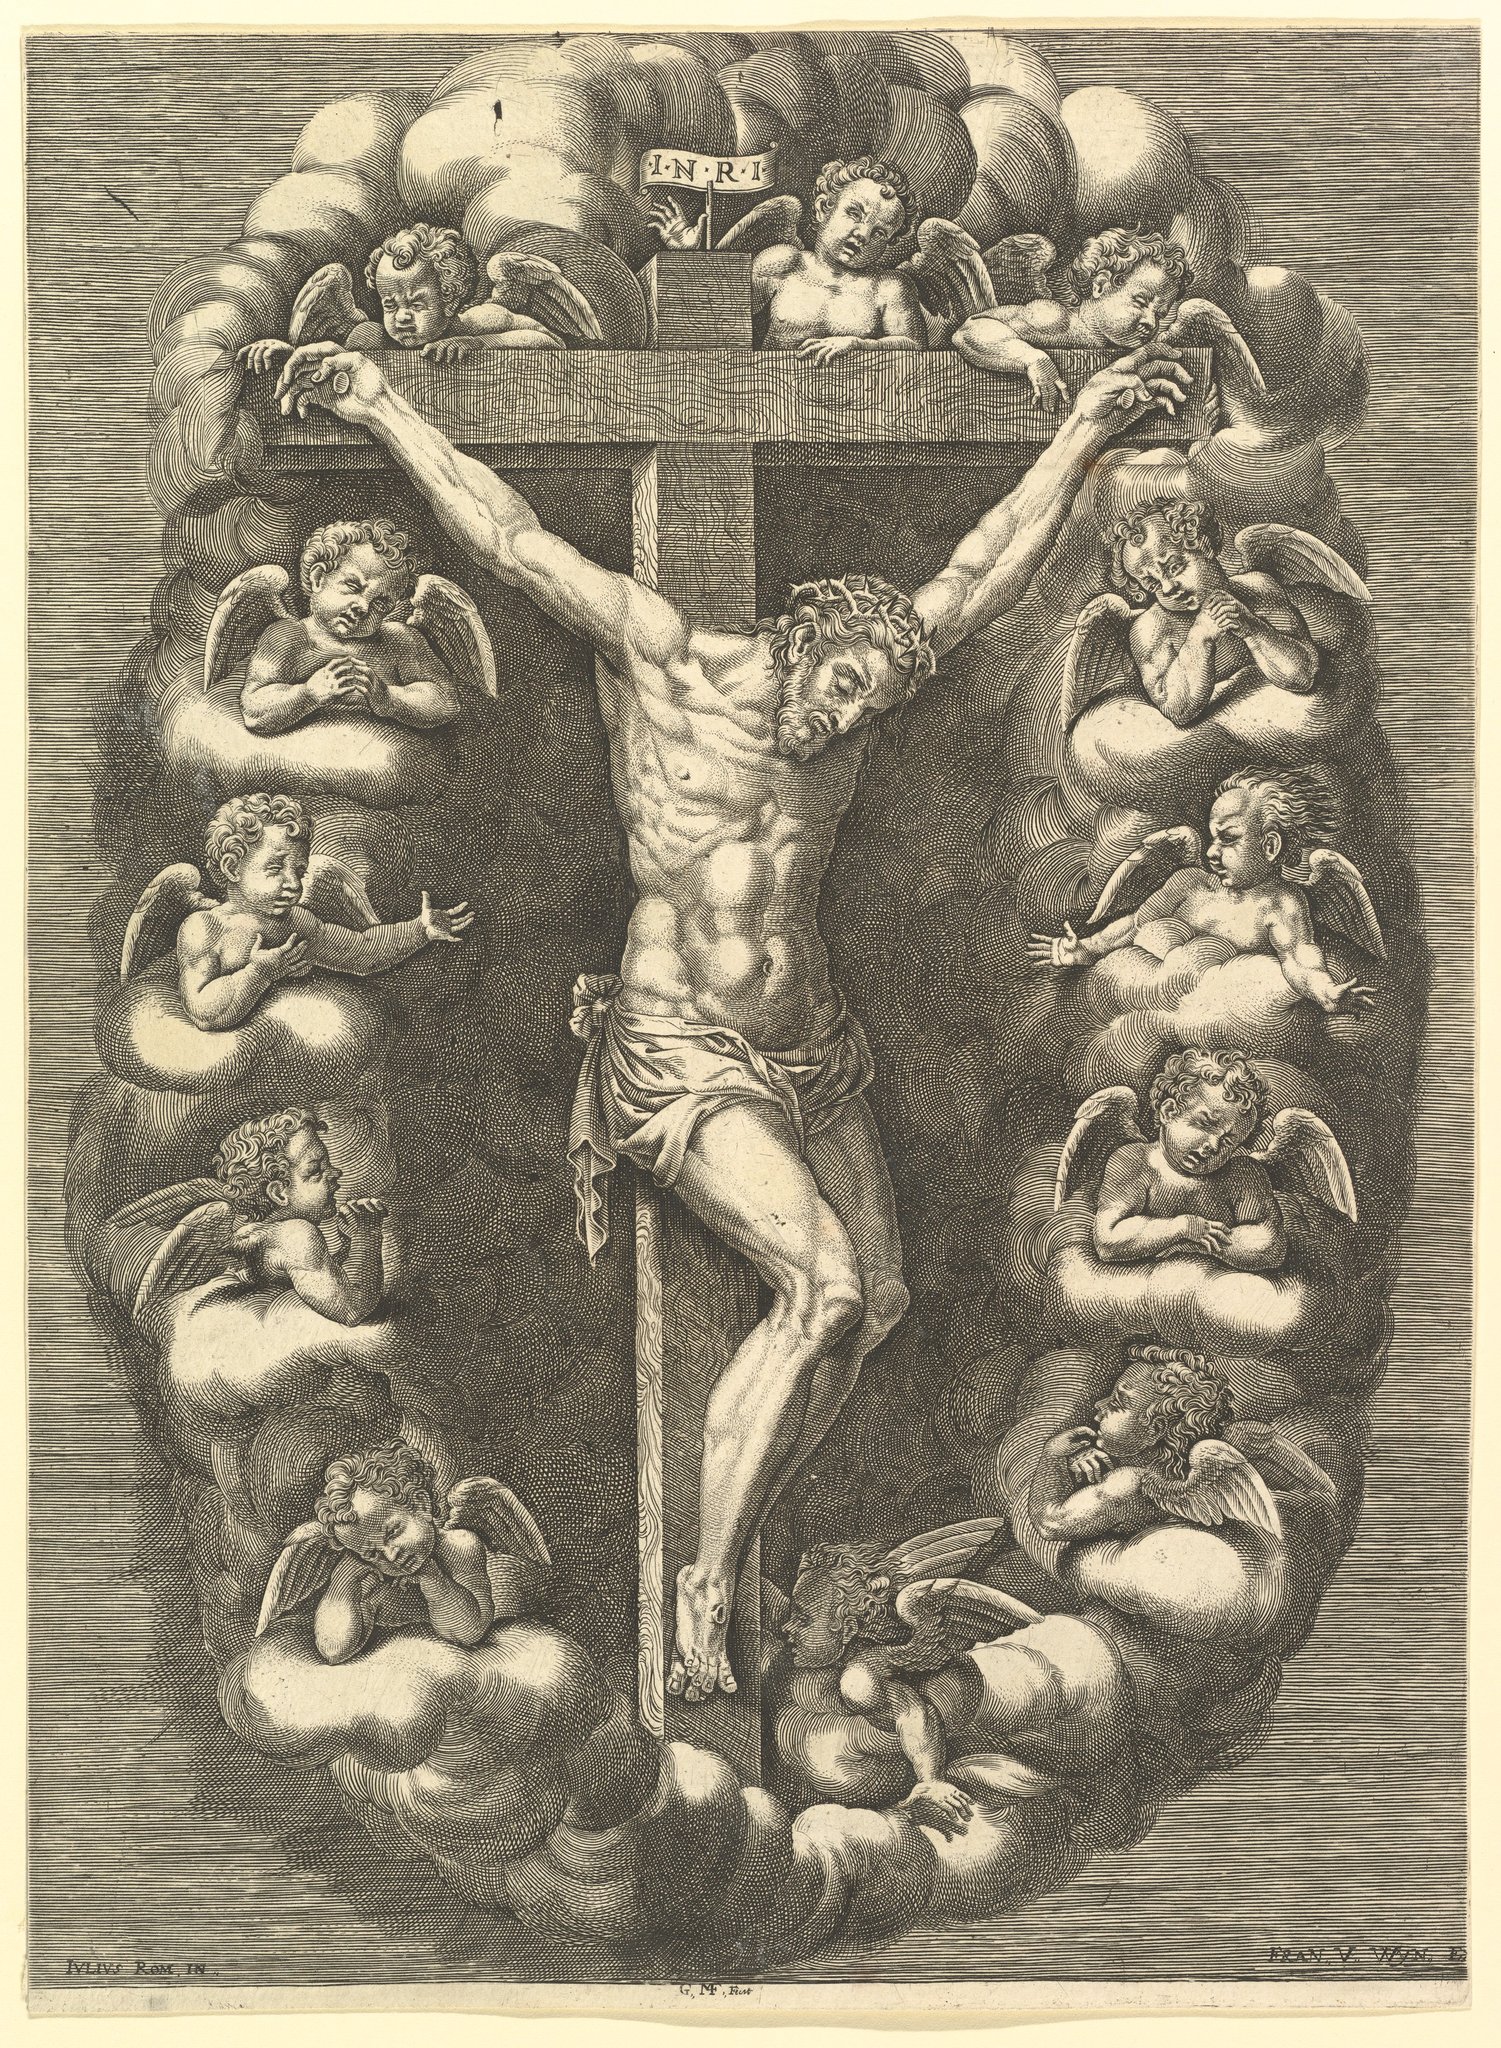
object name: print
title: The Crucified Christ Surrounded by Mourning Angels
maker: anonymous, italian, 16th century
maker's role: artist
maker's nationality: italian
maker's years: 1500-1600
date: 1575-1679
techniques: engraving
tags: angels,christ,crucifixion